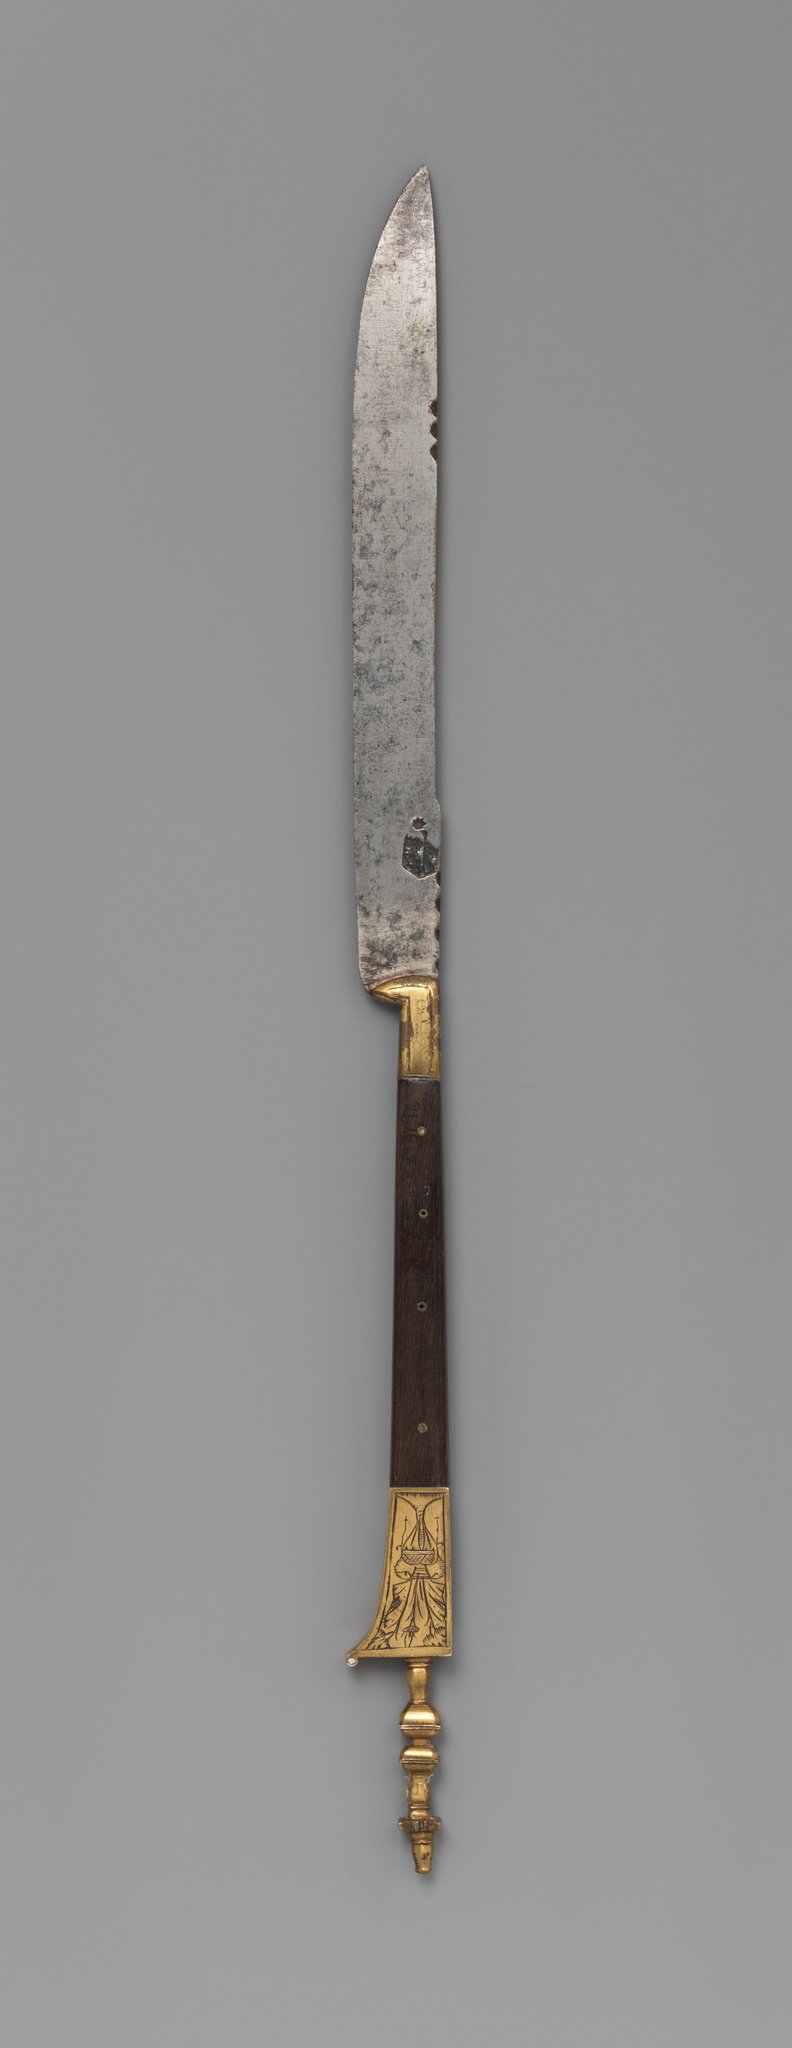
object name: table knife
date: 1601-1633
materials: gilt brass, steel, wood